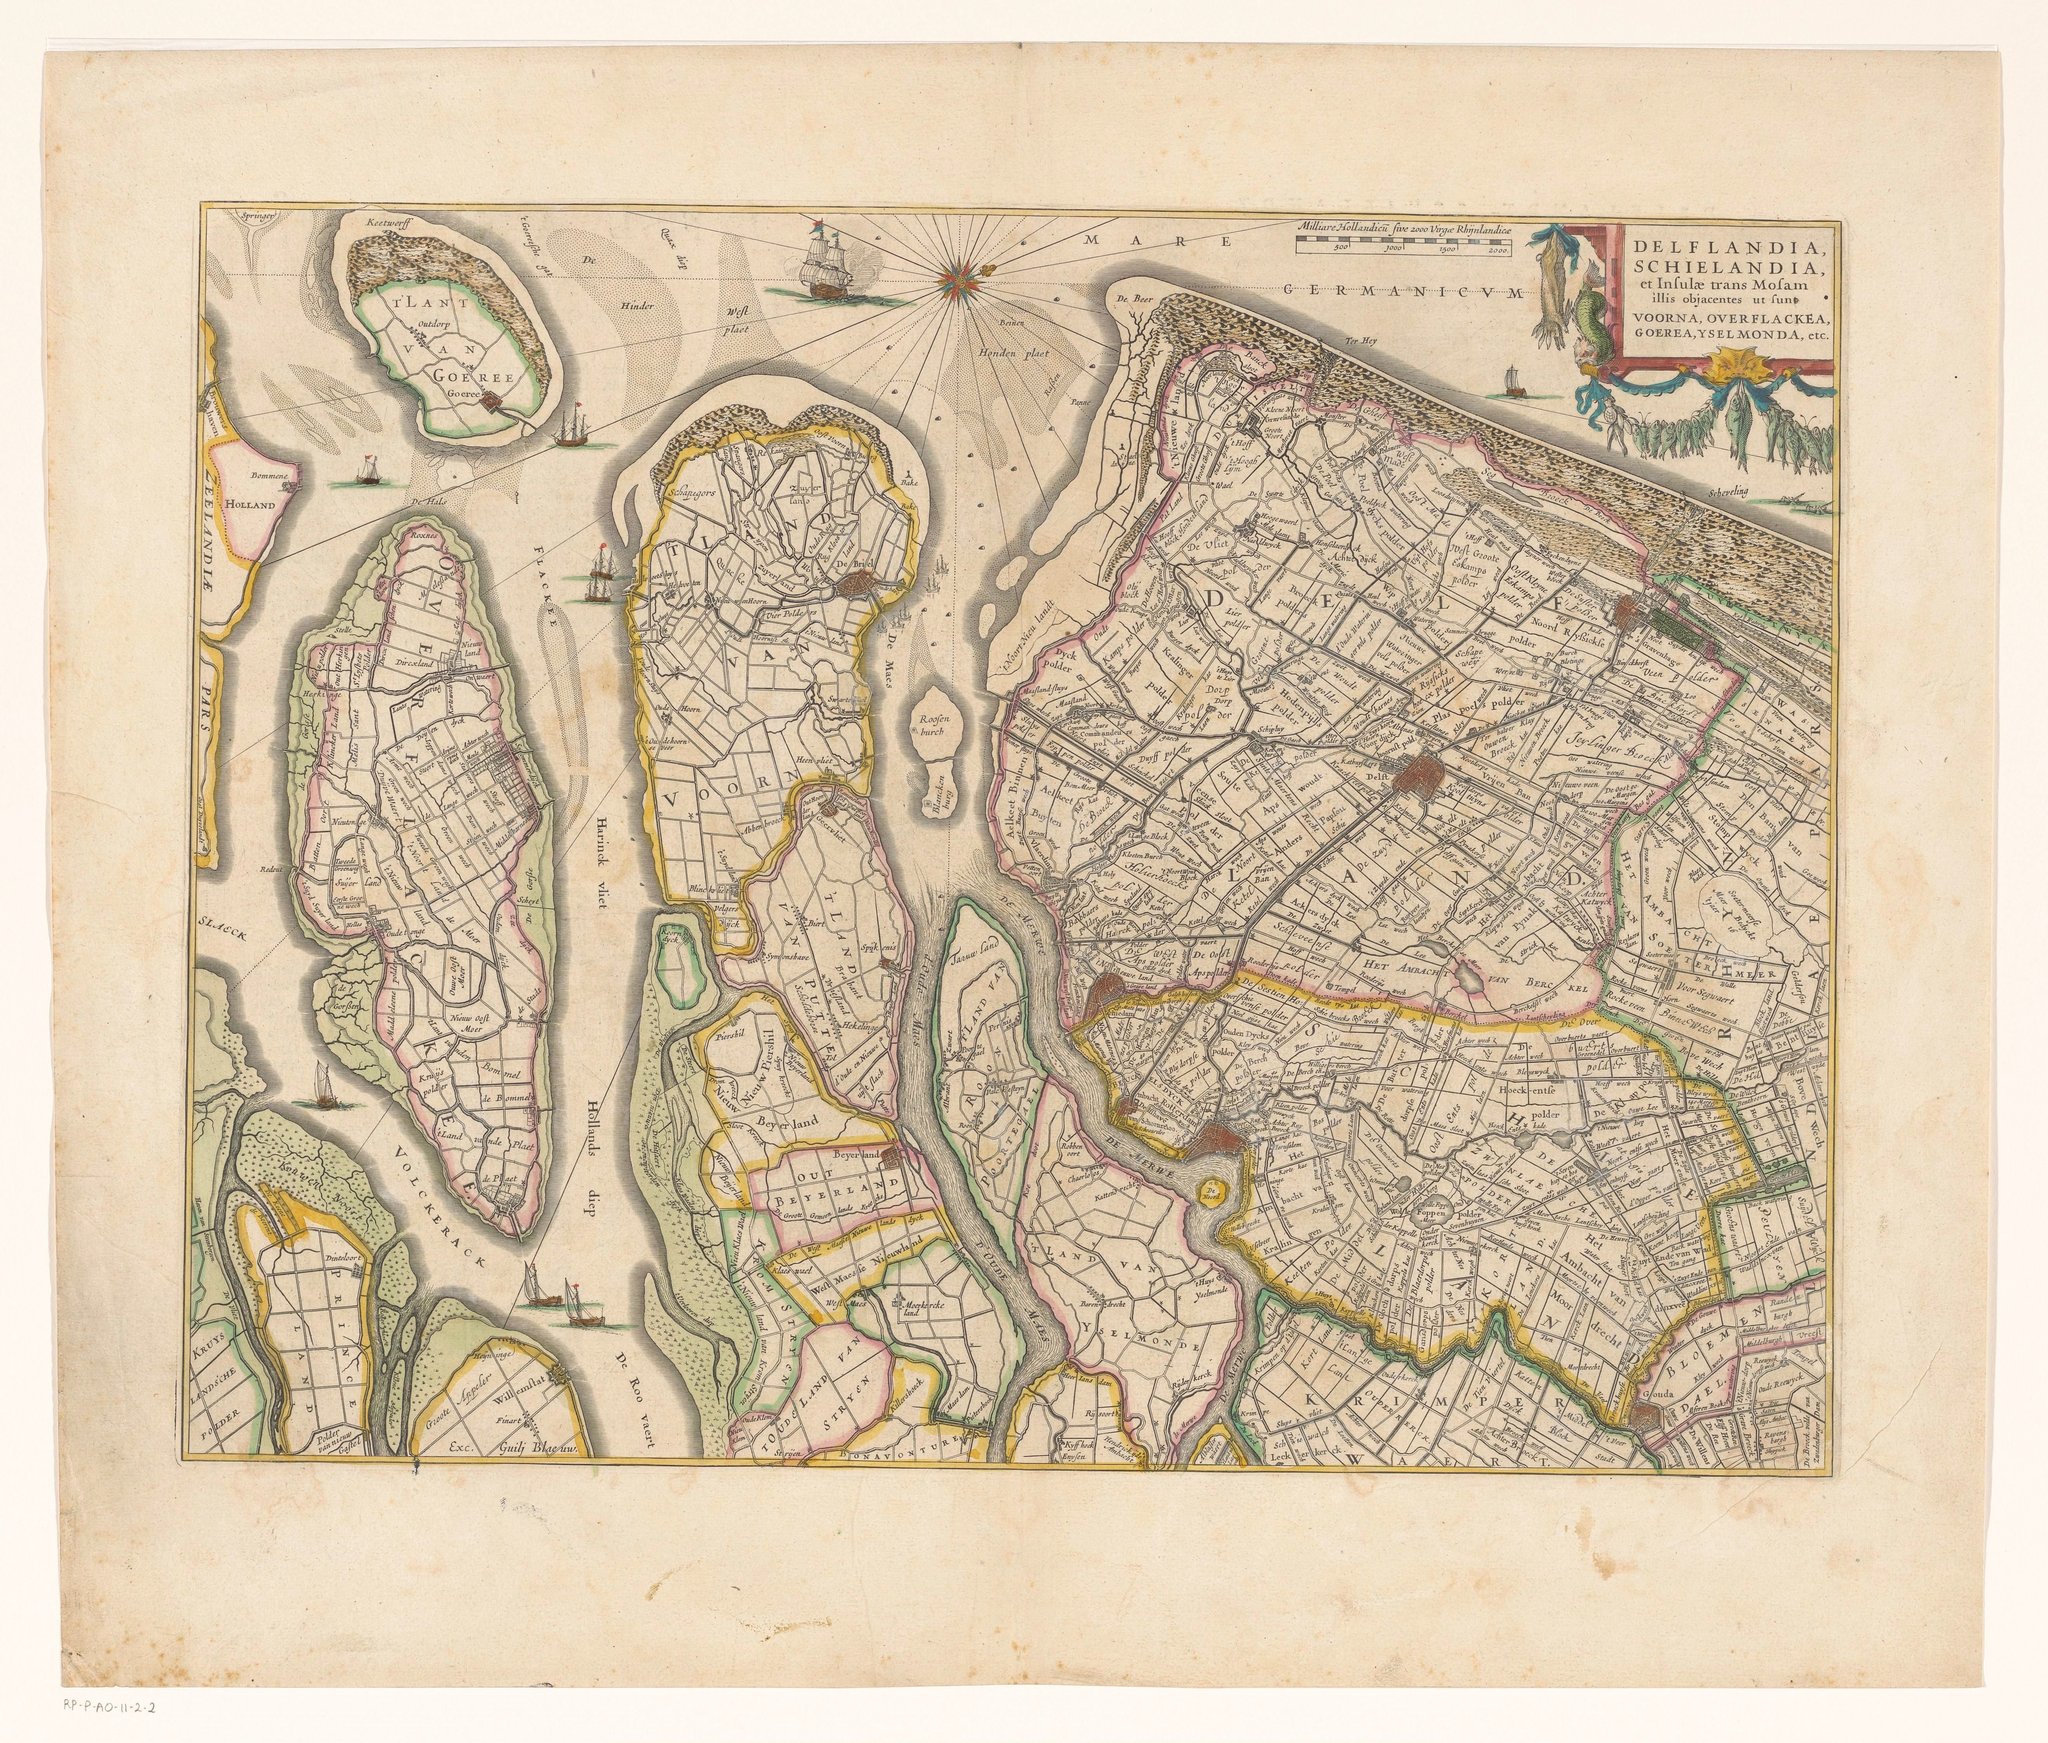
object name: map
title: Delflandia, Schielandia et insulae trans Mosam illis objacentes ut sunt Voorna, Overflackea, Goera, Yselmonda etc.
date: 1631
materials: paper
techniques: engraving, etching, hand coloring, letterpress printing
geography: amsterdam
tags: maps of separate countries or regions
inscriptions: collector's mark: Lugt 2228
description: Kaart van Delfland, Schieland en de Zuid-Hollandse eilanden (onder andere Voorne, Overflakkee, Goeree en IJsselmonde). Rechtsboven de titelcartouche. Links daarvan een schaalstok: Milliare Hollandicu[m] sive 2000 virgae Rhijnlandicae. Oriëntatie: noorden rechts. Op verso Nederlandse tekst.